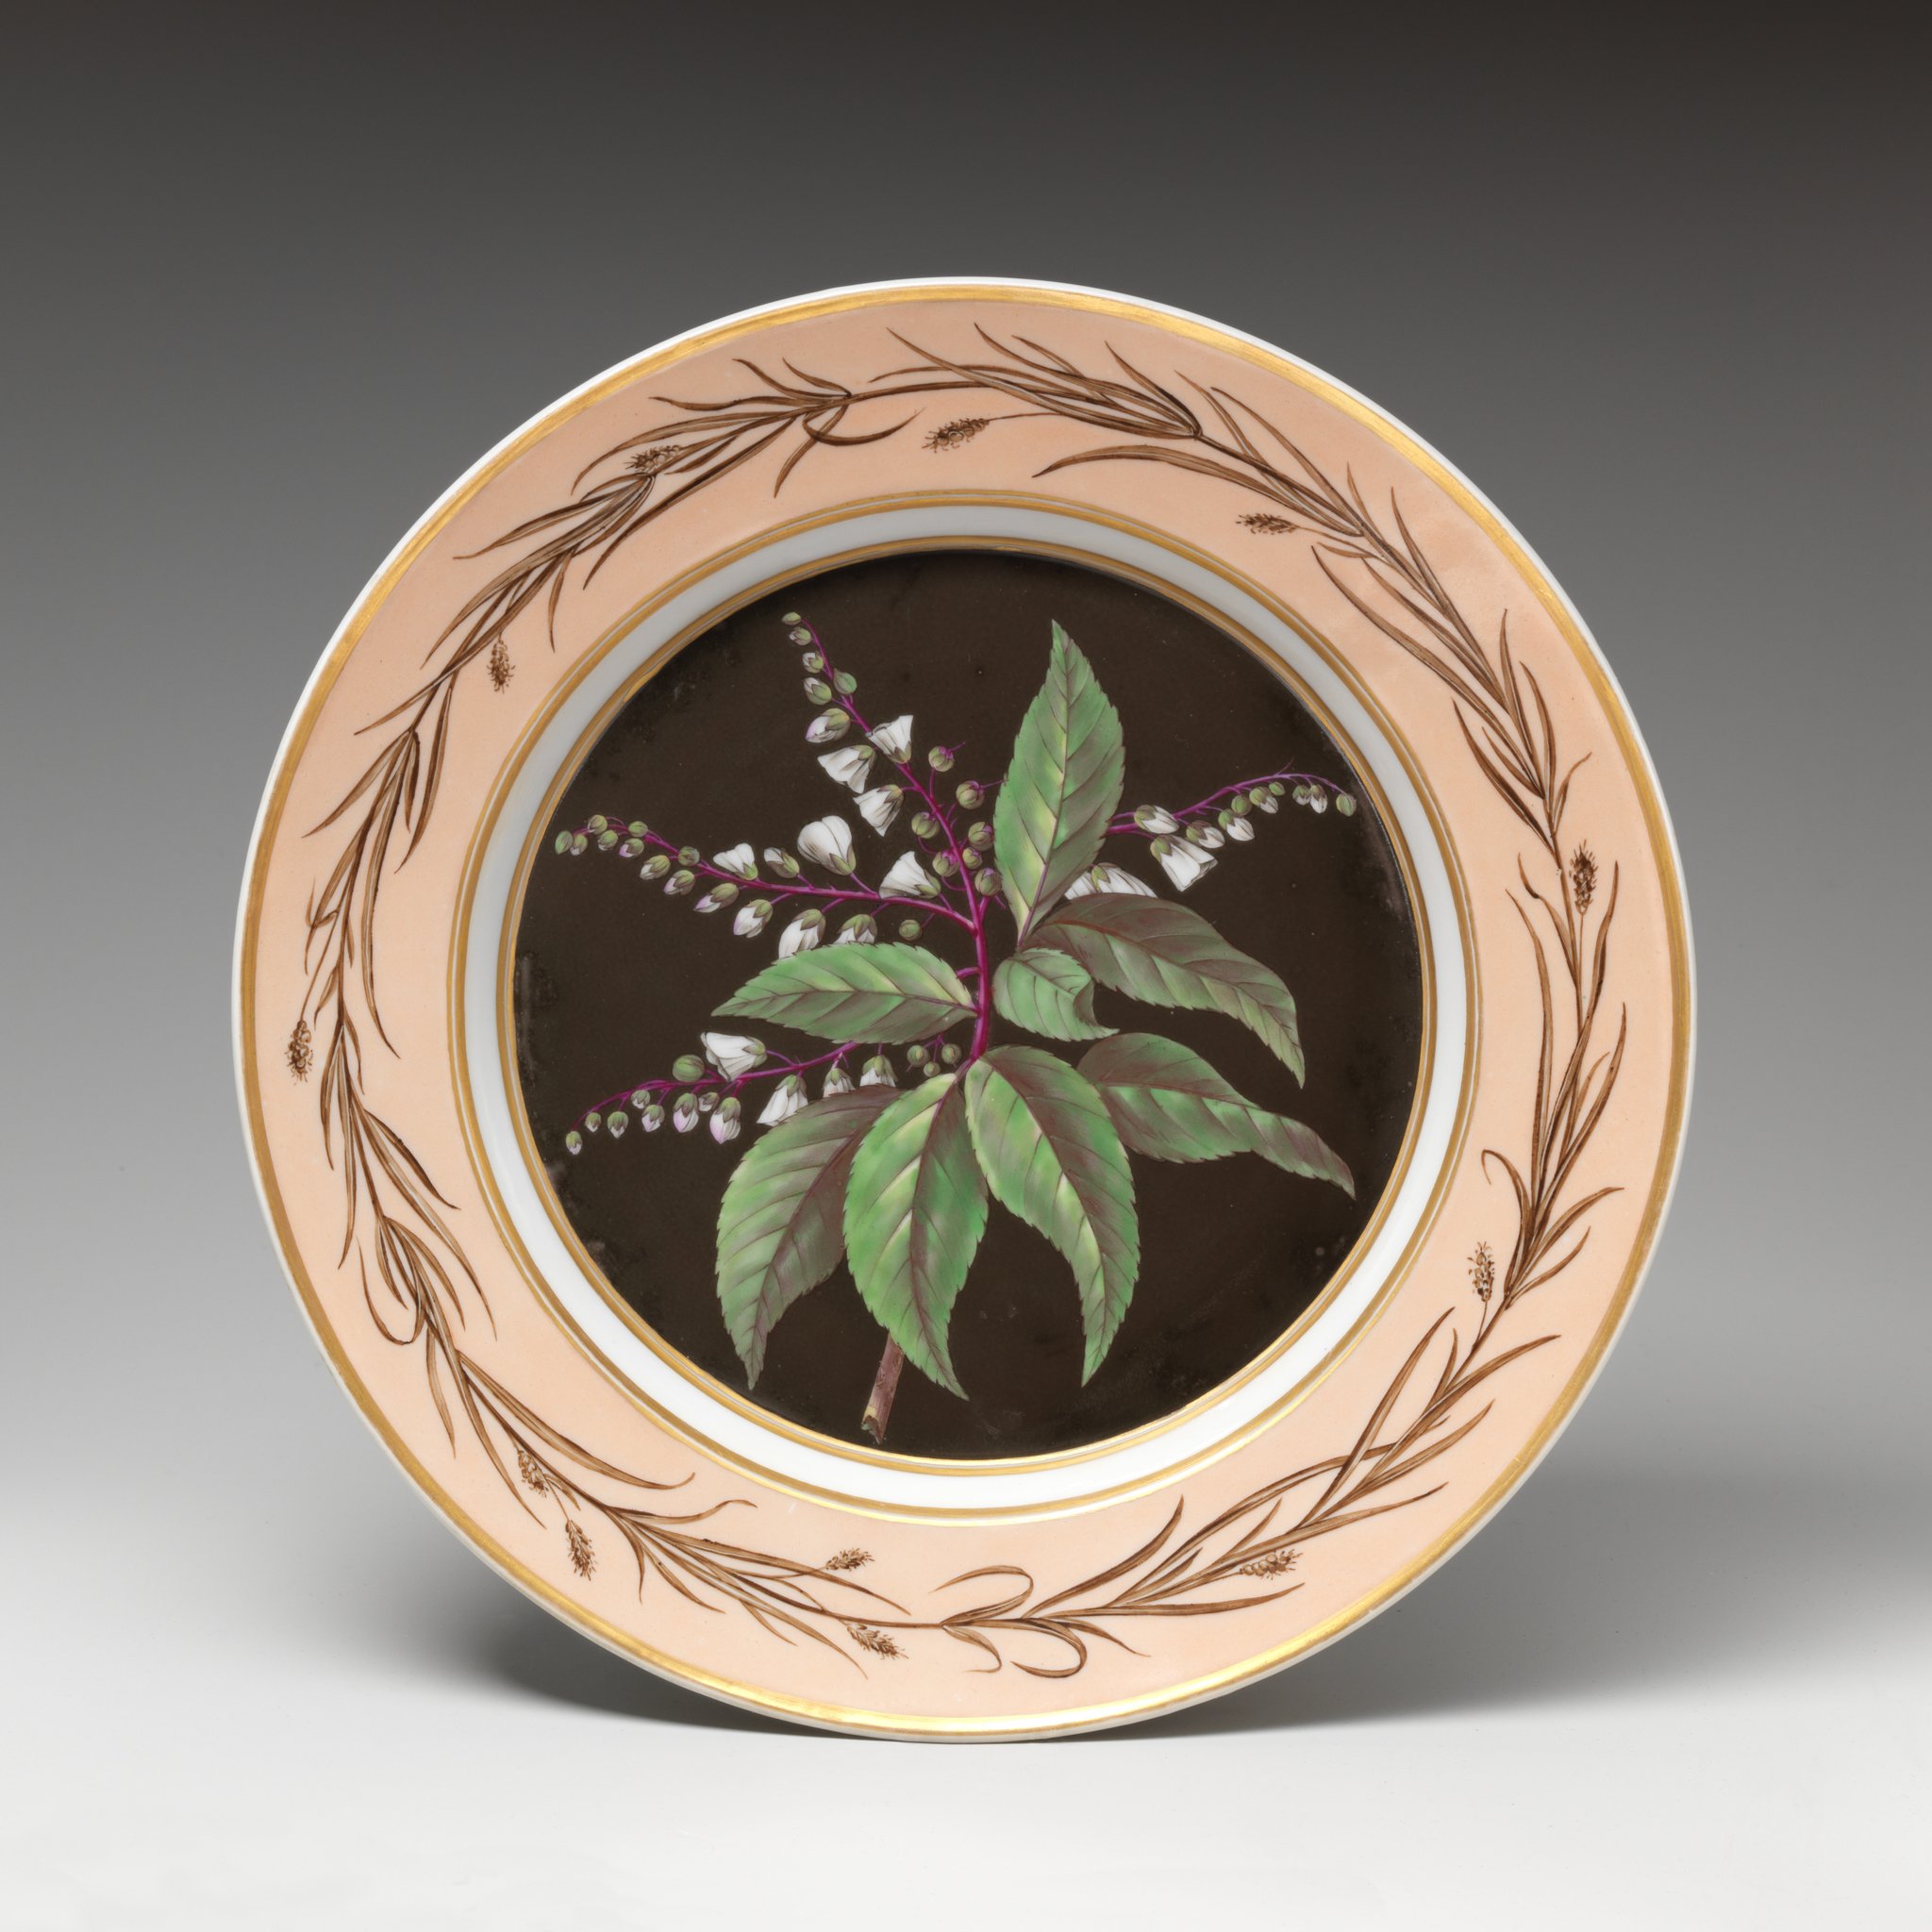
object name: plate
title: Plate with Lily of the Valley Tree (Clethra arborea)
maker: royal porcelain manufactory (königliche porzellan-manufaktur), berlin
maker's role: manufactory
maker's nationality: german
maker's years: 1763-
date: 1806-1809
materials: hard paste porcelain